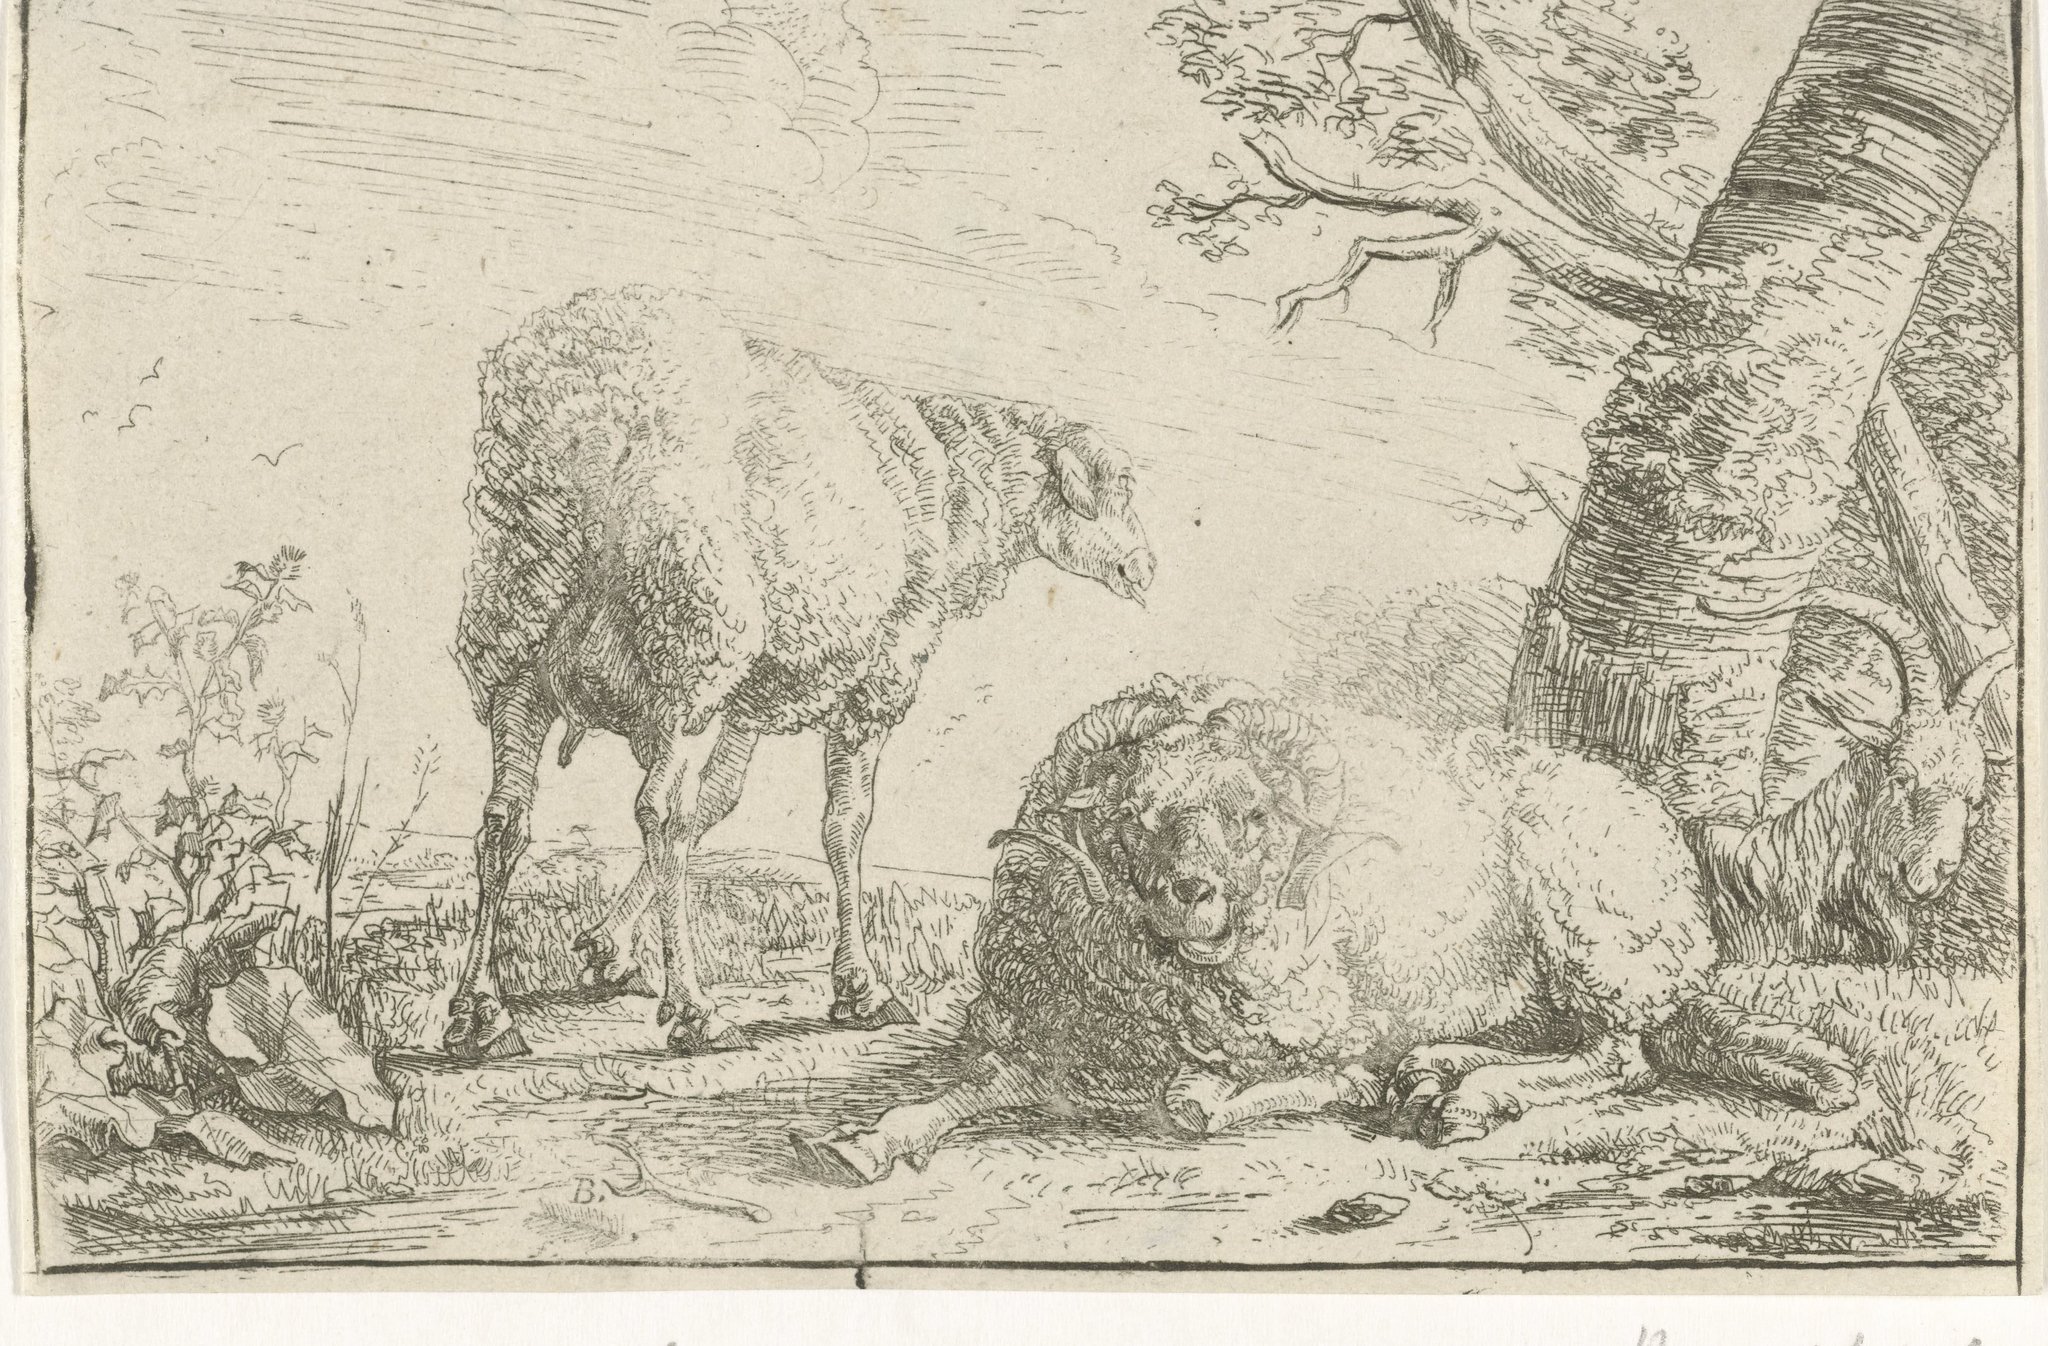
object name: print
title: Twee schapen en een geit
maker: barend graat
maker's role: draughtsman, print maker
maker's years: 1628-1709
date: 1638-1652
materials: paper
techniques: etching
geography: amsterdam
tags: ram, he-goat, billy-goat, ewe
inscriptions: collector's mark: Lugt 2228, collector's mark: Lugt 2610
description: De tweede staat is ook afgrdrukt in: Het geheele werk van den vermaarden landschap schilder Anth. Waterloo: bestaande in 136 landschappen, alle door hem zelf konstig geteekent en in 't koper gemaakt. Amsterdam 1652.